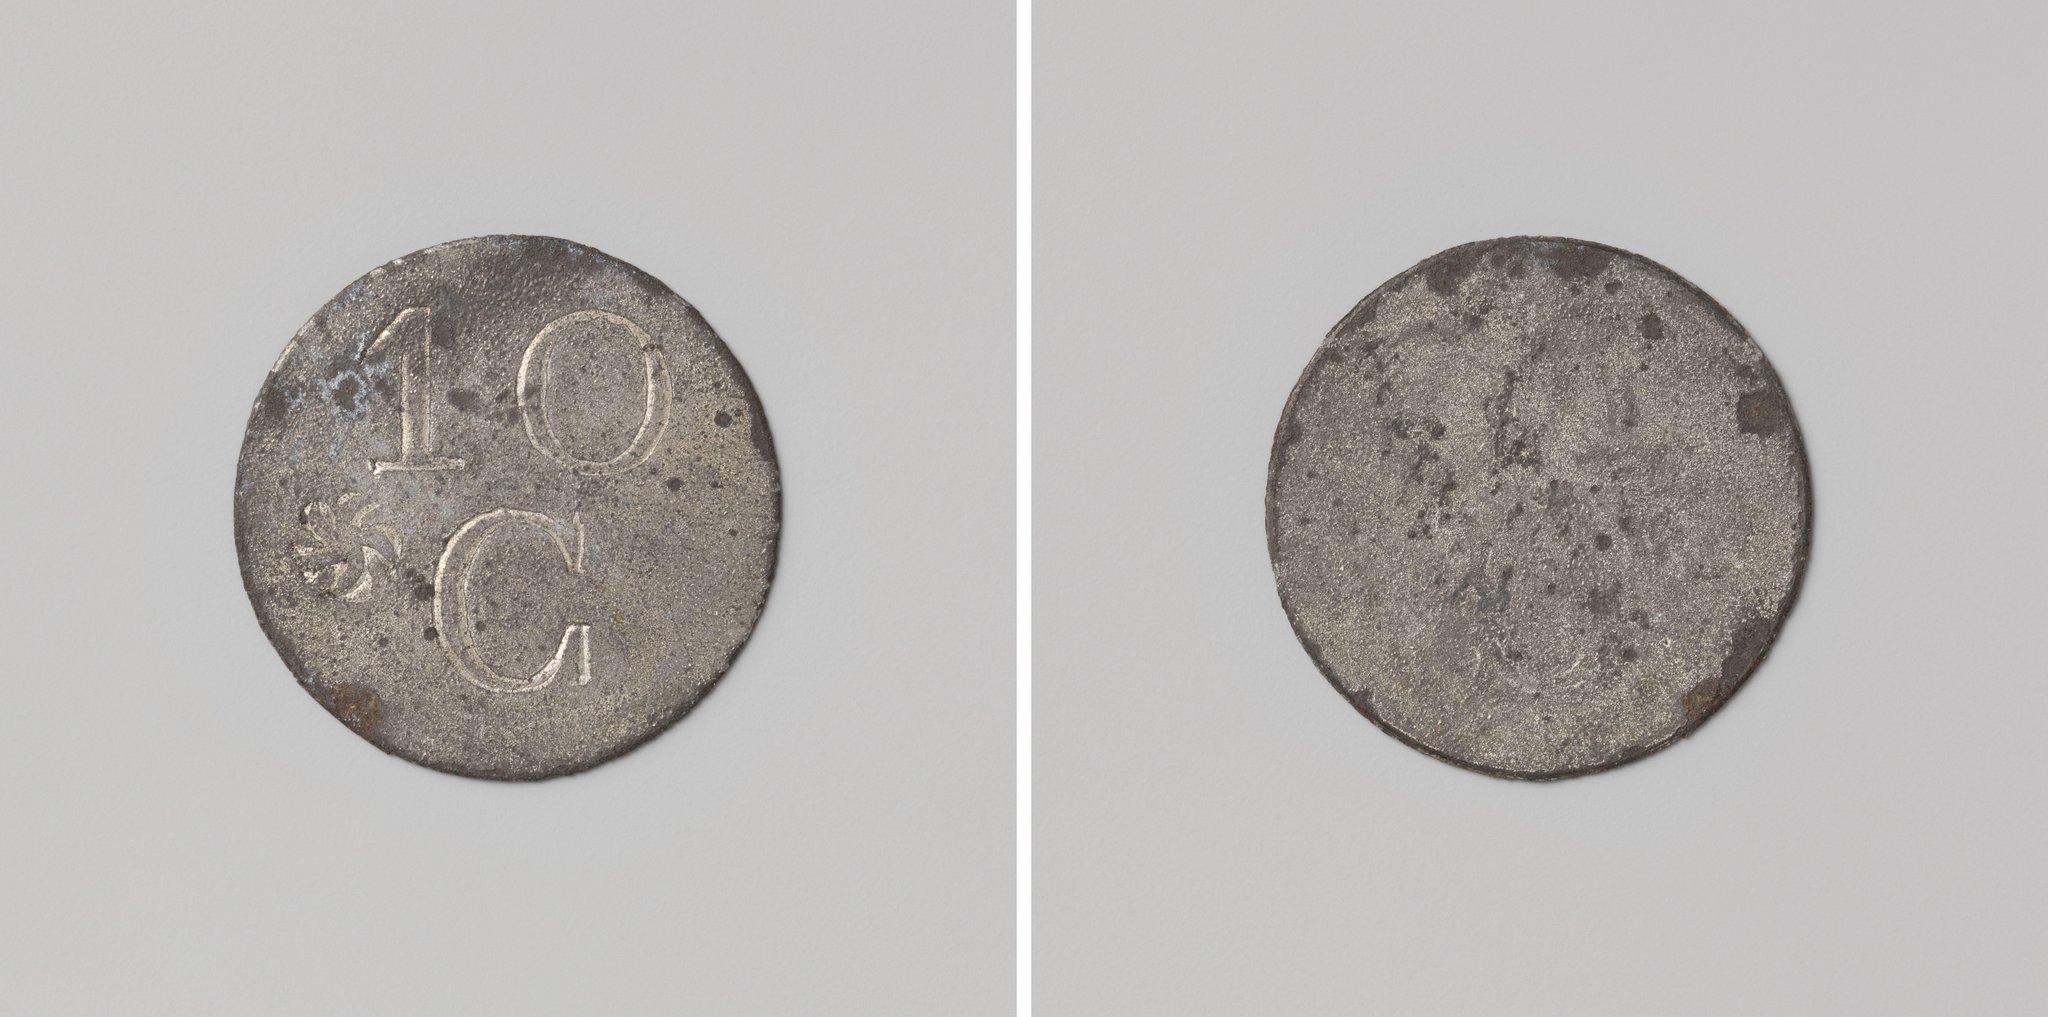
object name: monetary token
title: Strafgevangenis te 's-Hertogenbosch, huismunt ter waarde van tien cent. In de periode 1824-1830 in 's-Hertogenbosch gebruikt, daarna in de periode 1831-1834 in Gouda en Woerden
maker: hendrikus wansink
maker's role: blikslager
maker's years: 1778-1869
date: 1824-1834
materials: metal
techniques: striking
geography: den bosch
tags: den bosch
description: eenzijdige betaalpenning. Voorzijde: waardeaanduiding; links onder: vijfbladige rozet. Keerzijde: blanco